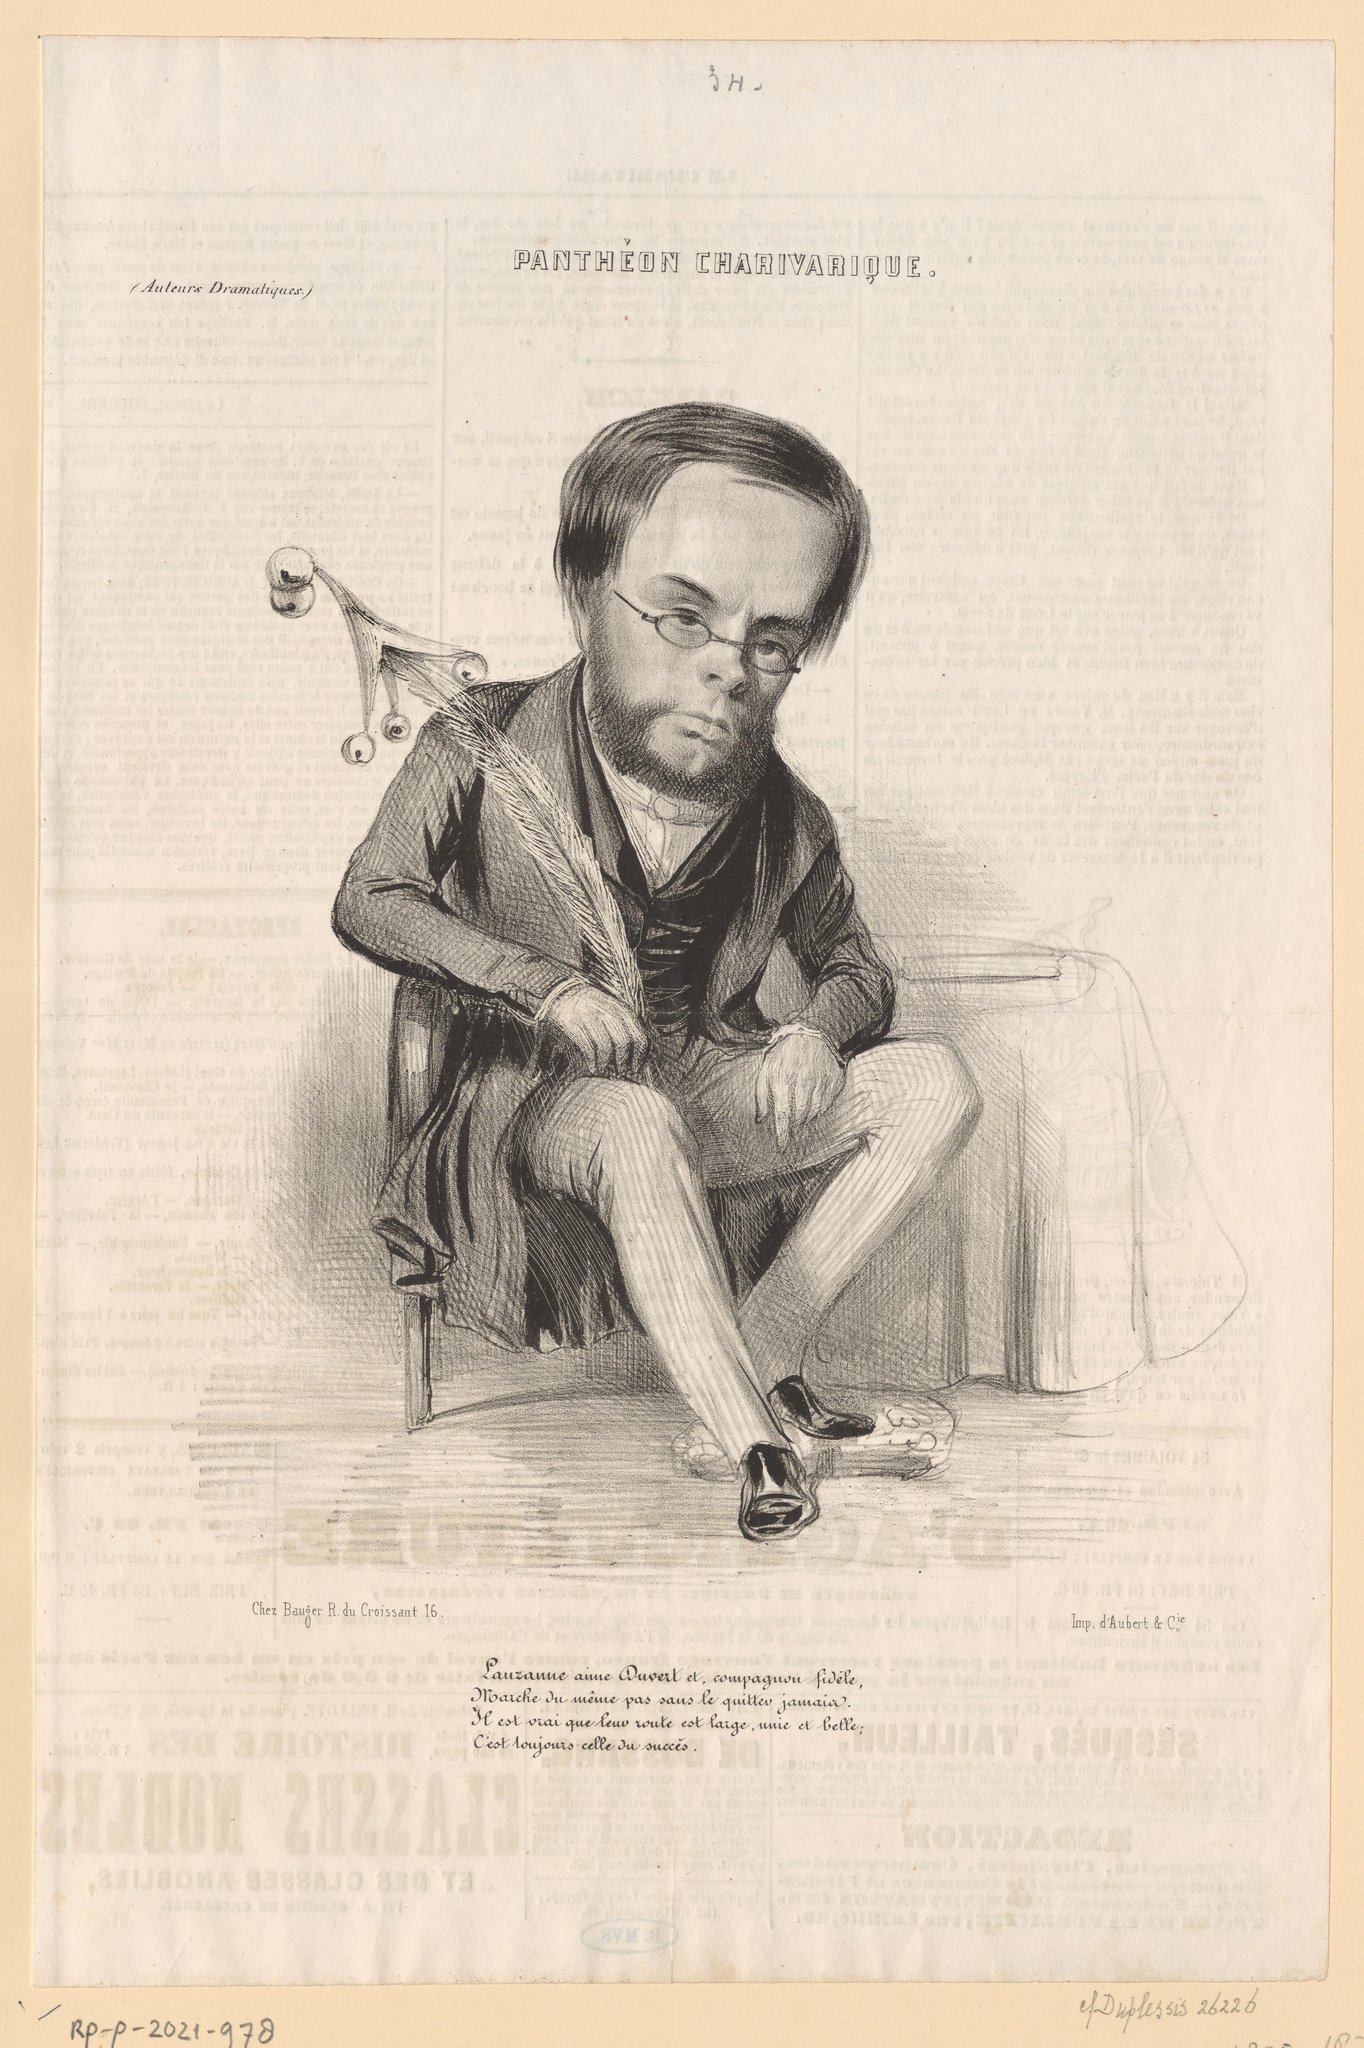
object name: print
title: Panthéon Charivarique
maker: Anonymous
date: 1838-1841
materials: paper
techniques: letterpress printing, lithograph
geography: paris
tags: historical persons, portrait of a writer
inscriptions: collector's mark: Lugt 2228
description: Uit de serie: Panthéon charivarique, bestaande uit 100 portretten van tekenaars, schrijvers, schilders, beeldhouwers, musici en acteurs. Prent komt uit een editie van Le Charivari, ca. 1838-1841.